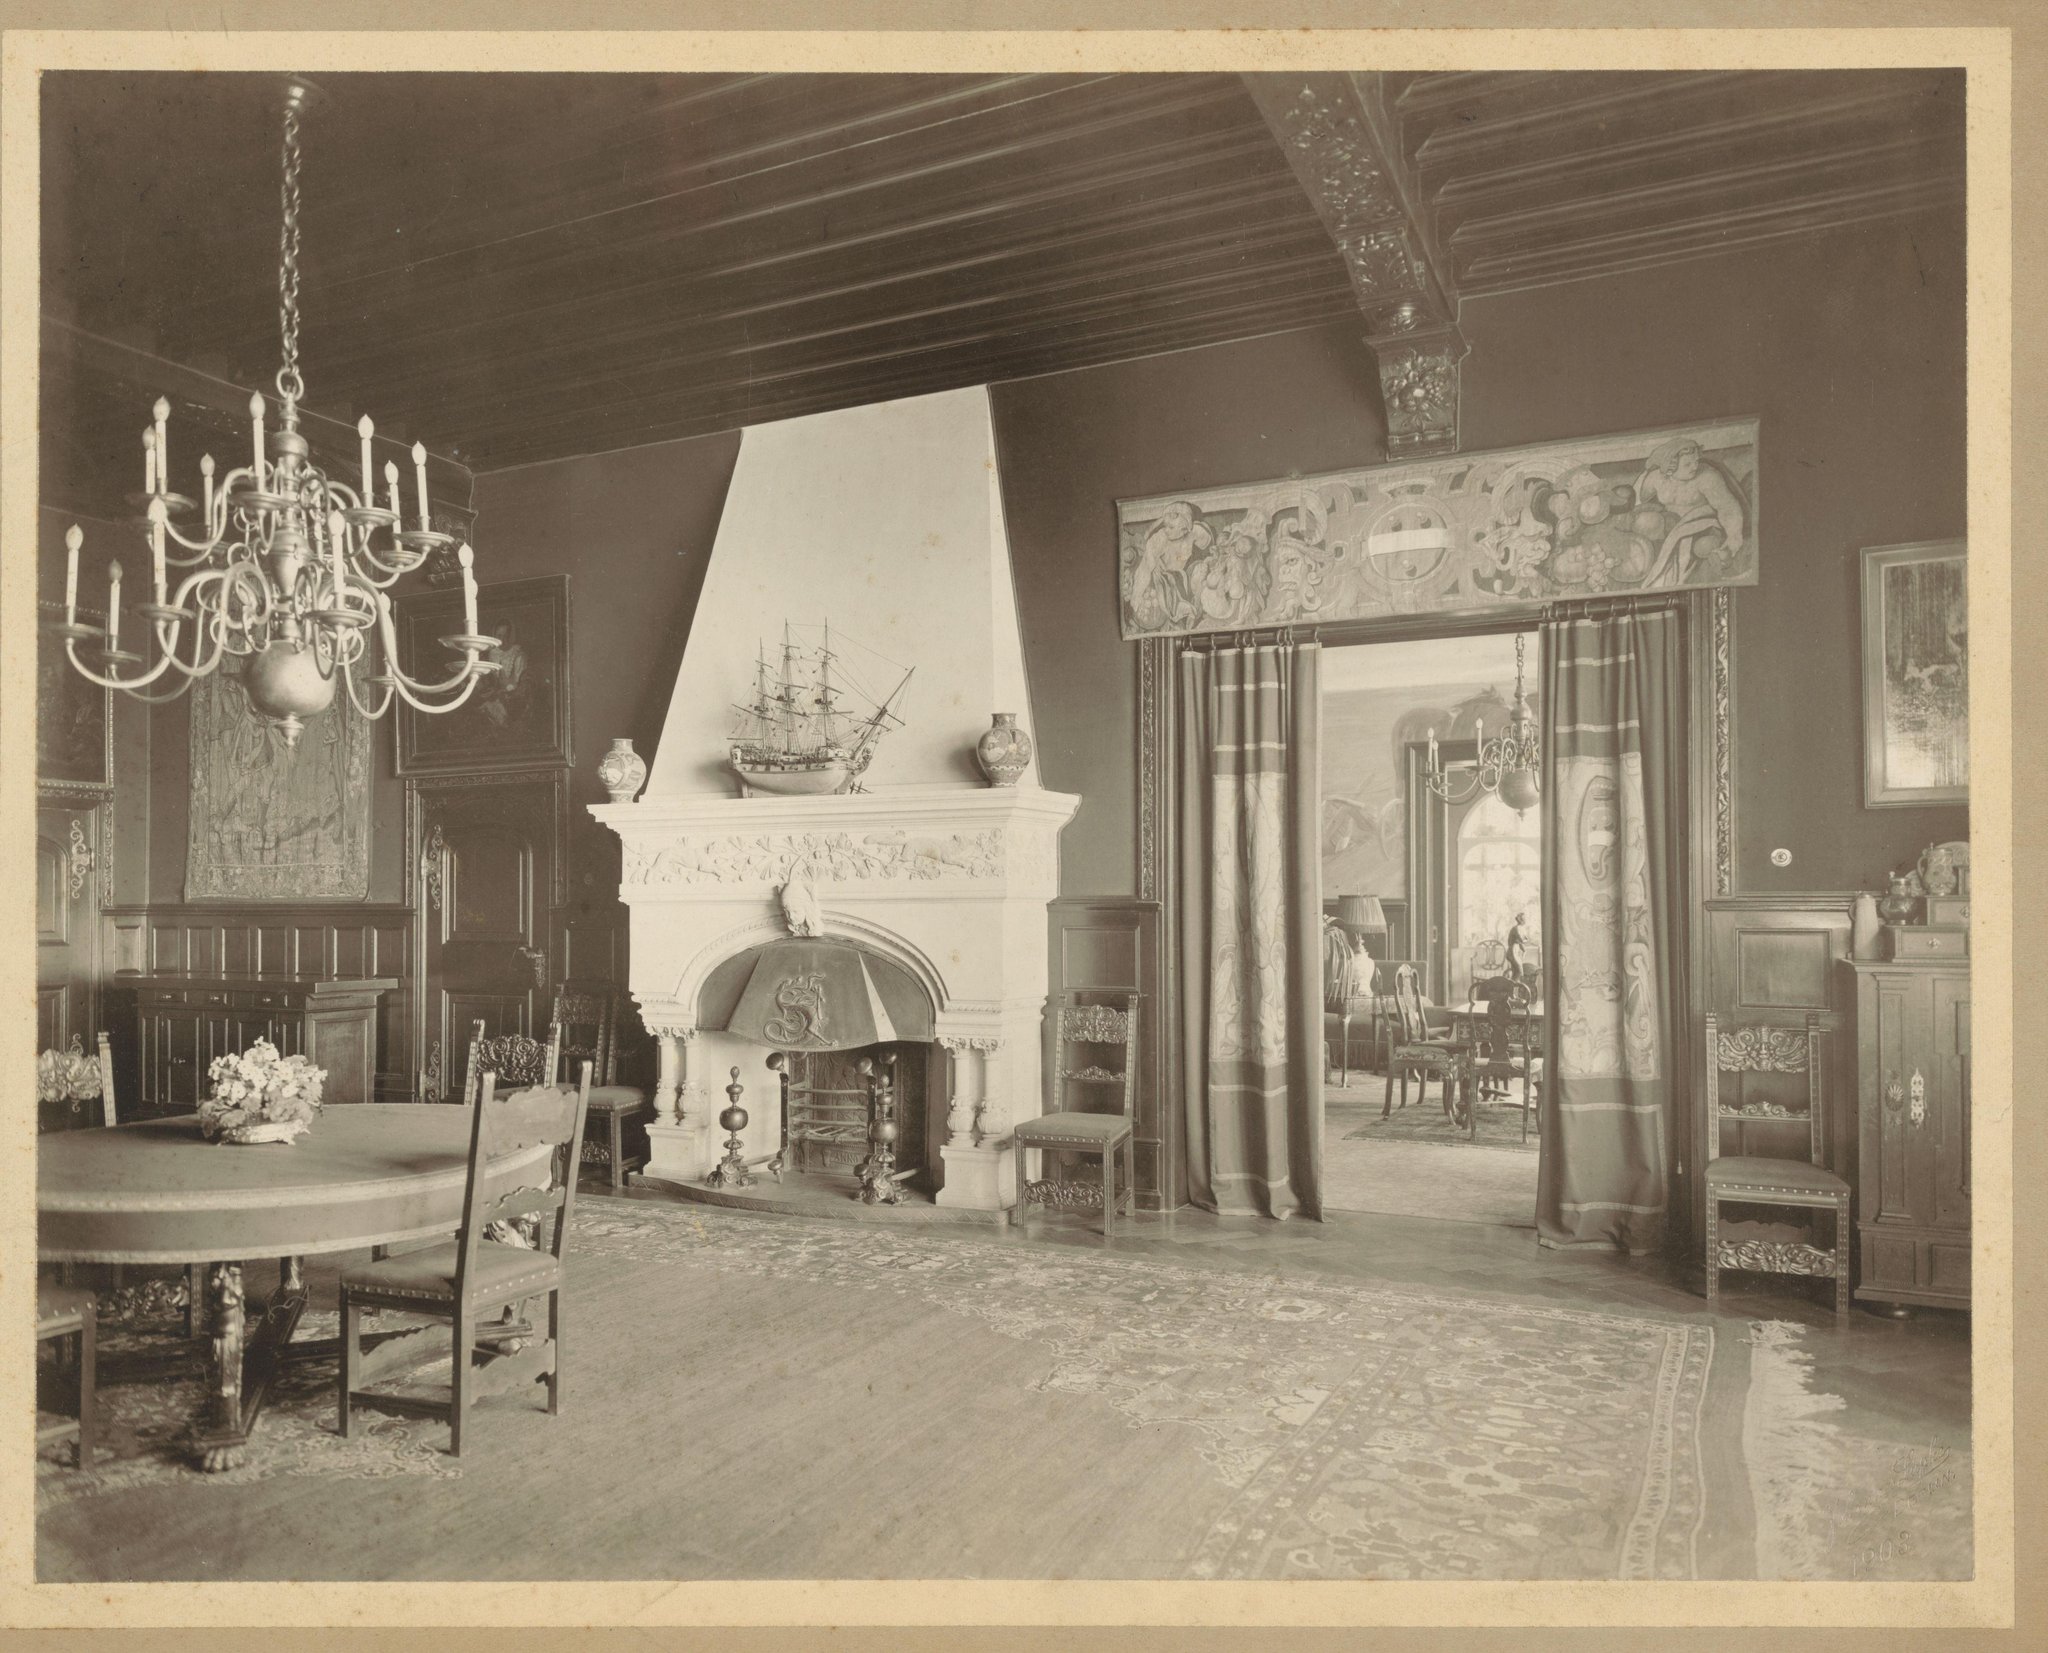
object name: photomechanical print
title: Eßzimmer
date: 1903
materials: cardboard, paper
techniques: woodburytype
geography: berlin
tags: chimney-piece, mantelpiece, dining-room, berlin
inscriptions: check stamp: ‘Johannes Lüpke/ Berlin/ 1903’